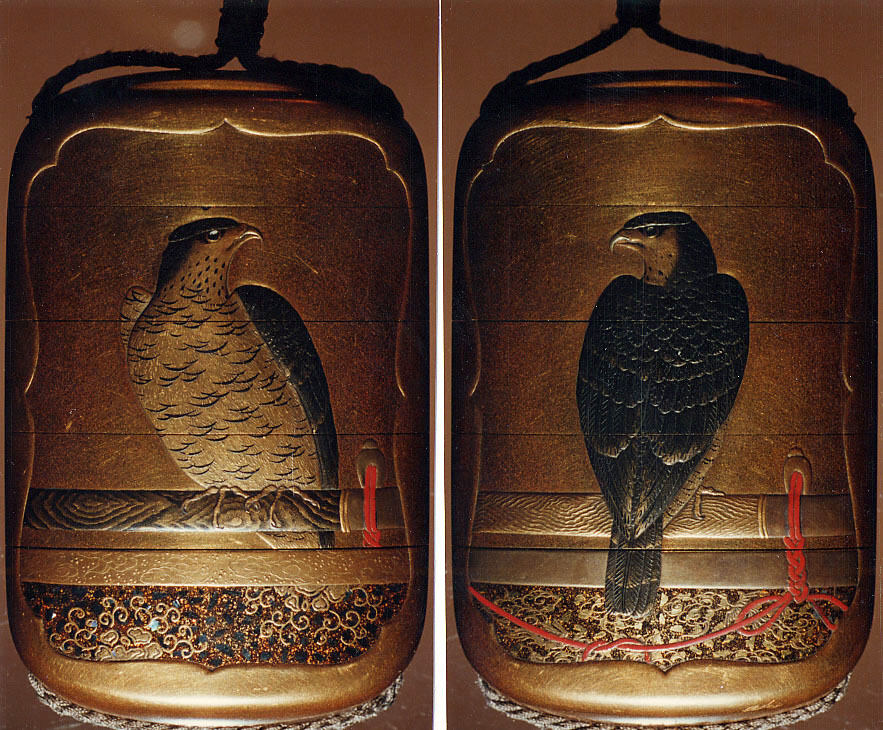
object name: inrō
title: Case (Inrō) with Design of a Perched Hawk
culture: japanese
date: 1801-1900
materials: gold, lacquer, silver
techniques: fundame, hiramakie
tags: hawks